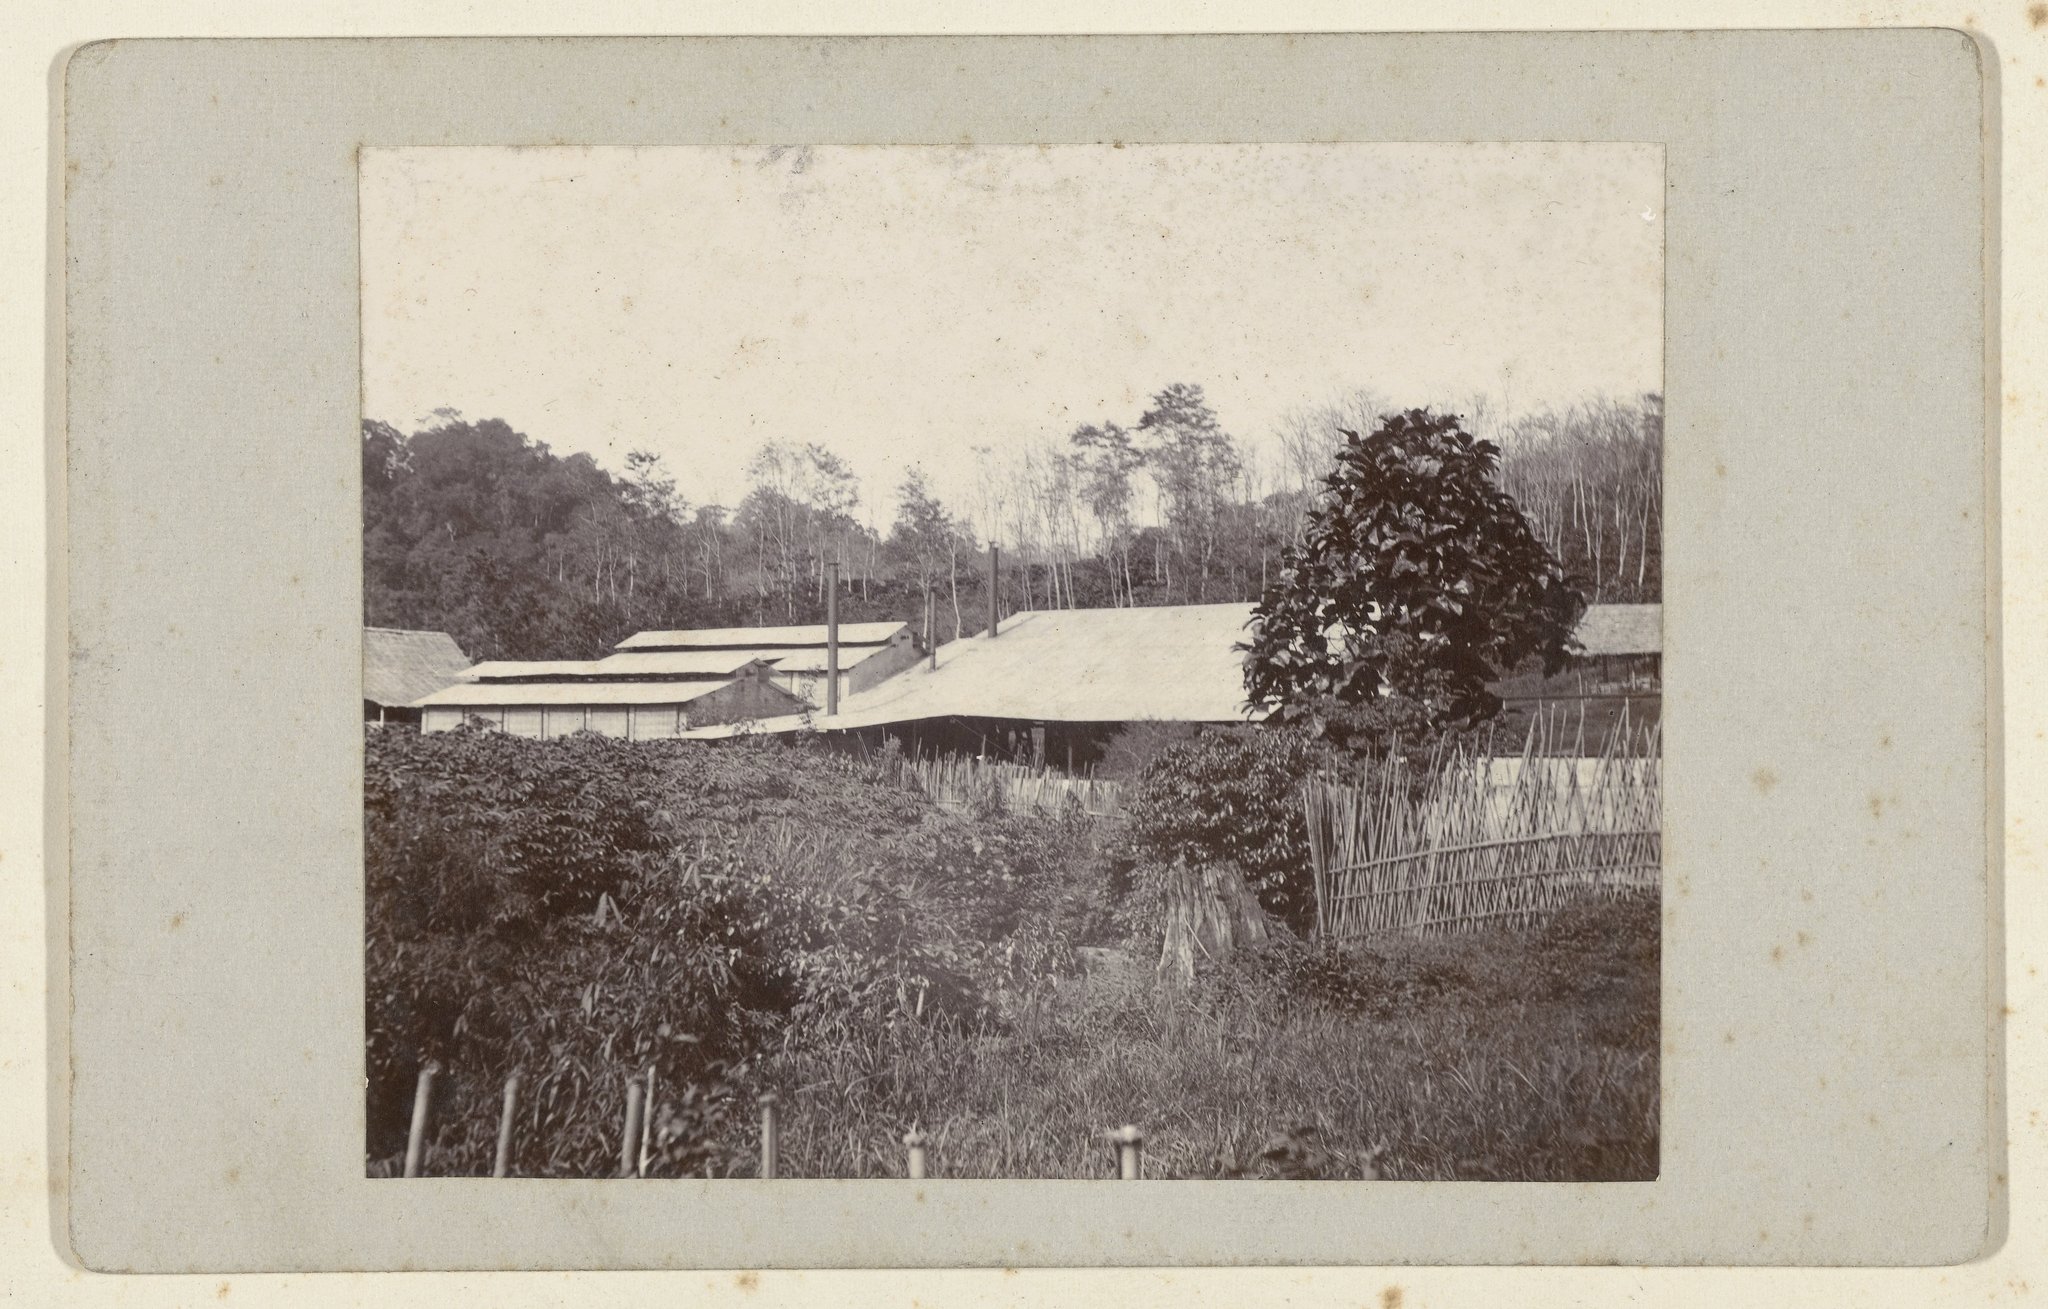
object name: photograph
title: Fabrieksterrein van Silo Sanen in Indoensië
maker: Anonymous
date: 1890-1910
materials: cardboard, paper, photographic support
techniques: gelatin silver print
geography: indonesia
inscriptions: title: ‘N 12 Silo Sanen Etablissement van den ... van de Kampong genomen.’